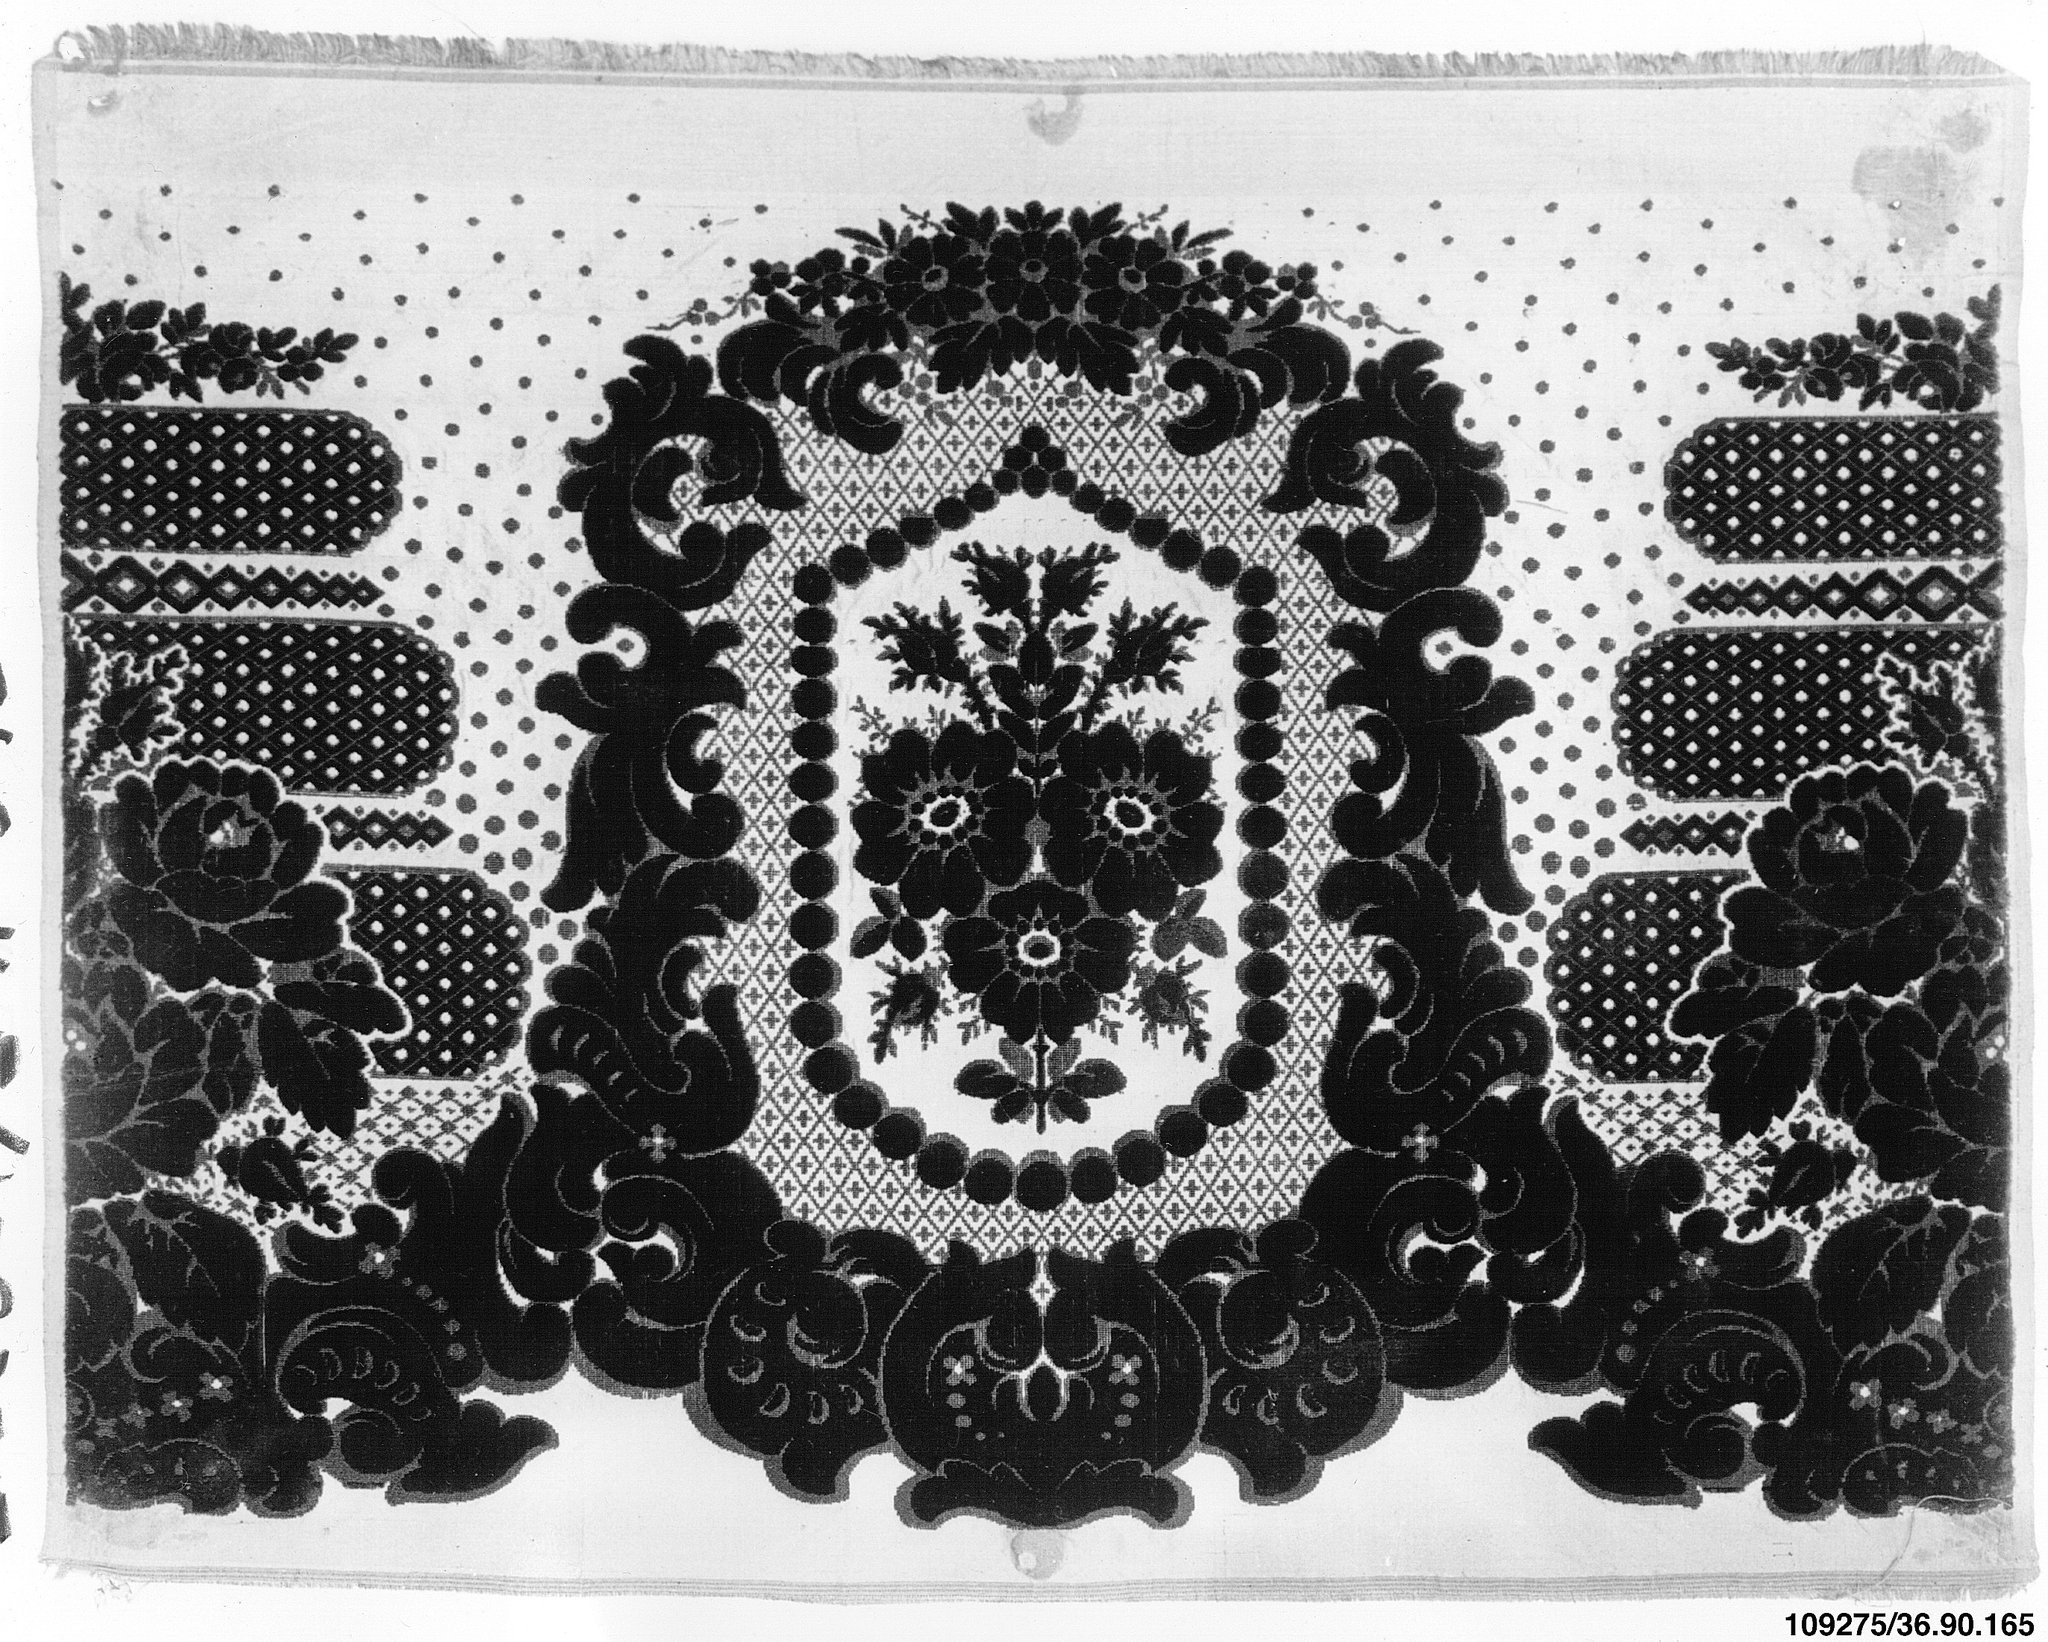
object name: border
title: Dress border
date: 1801-1900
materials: silk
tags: flowers